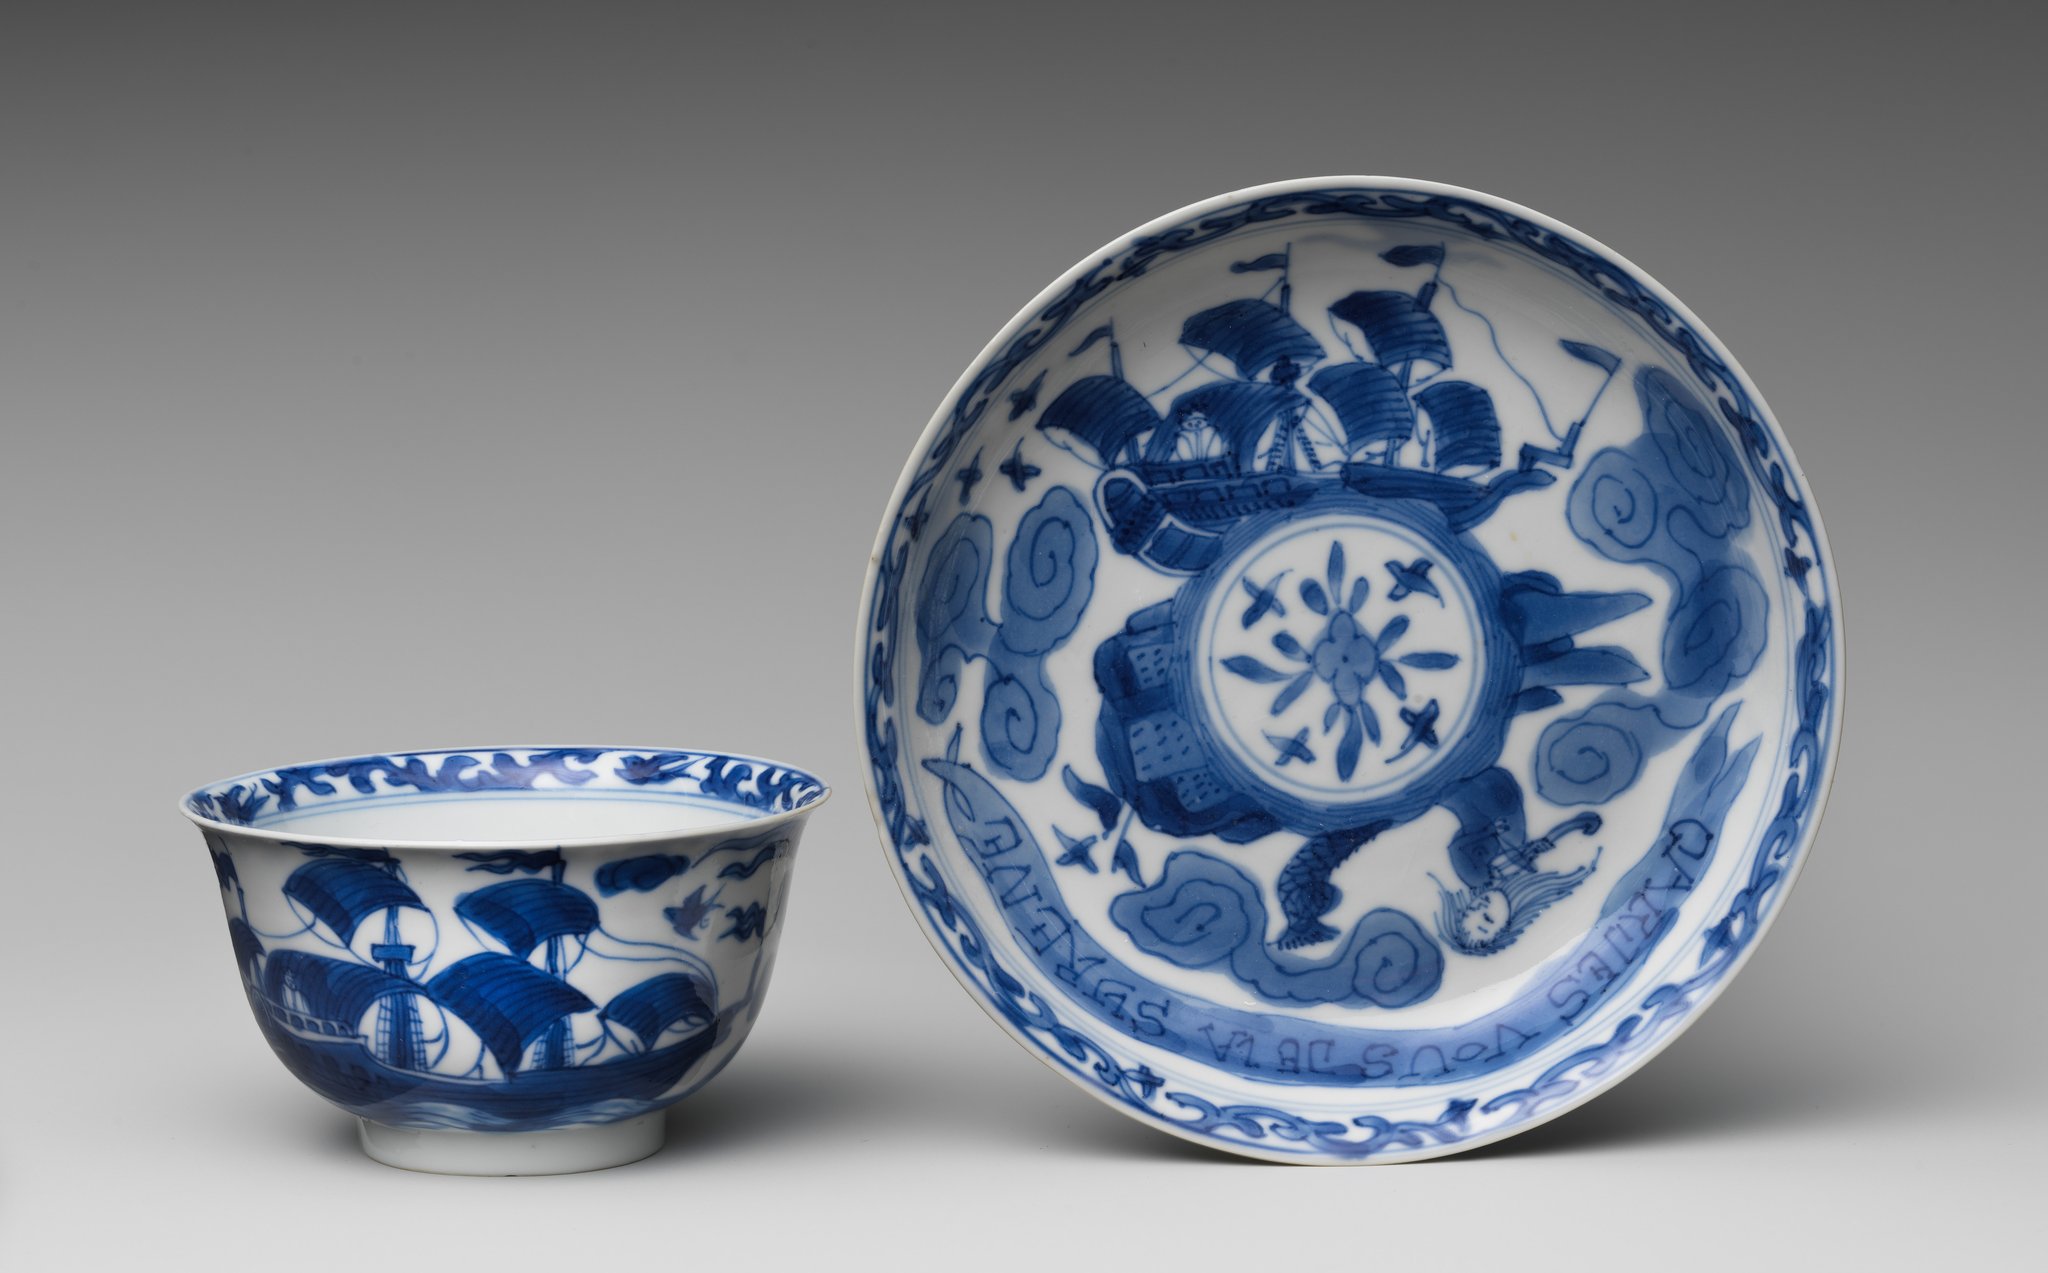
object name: cup and saucer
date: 1701-1733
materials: hard paste porcelain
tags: ships